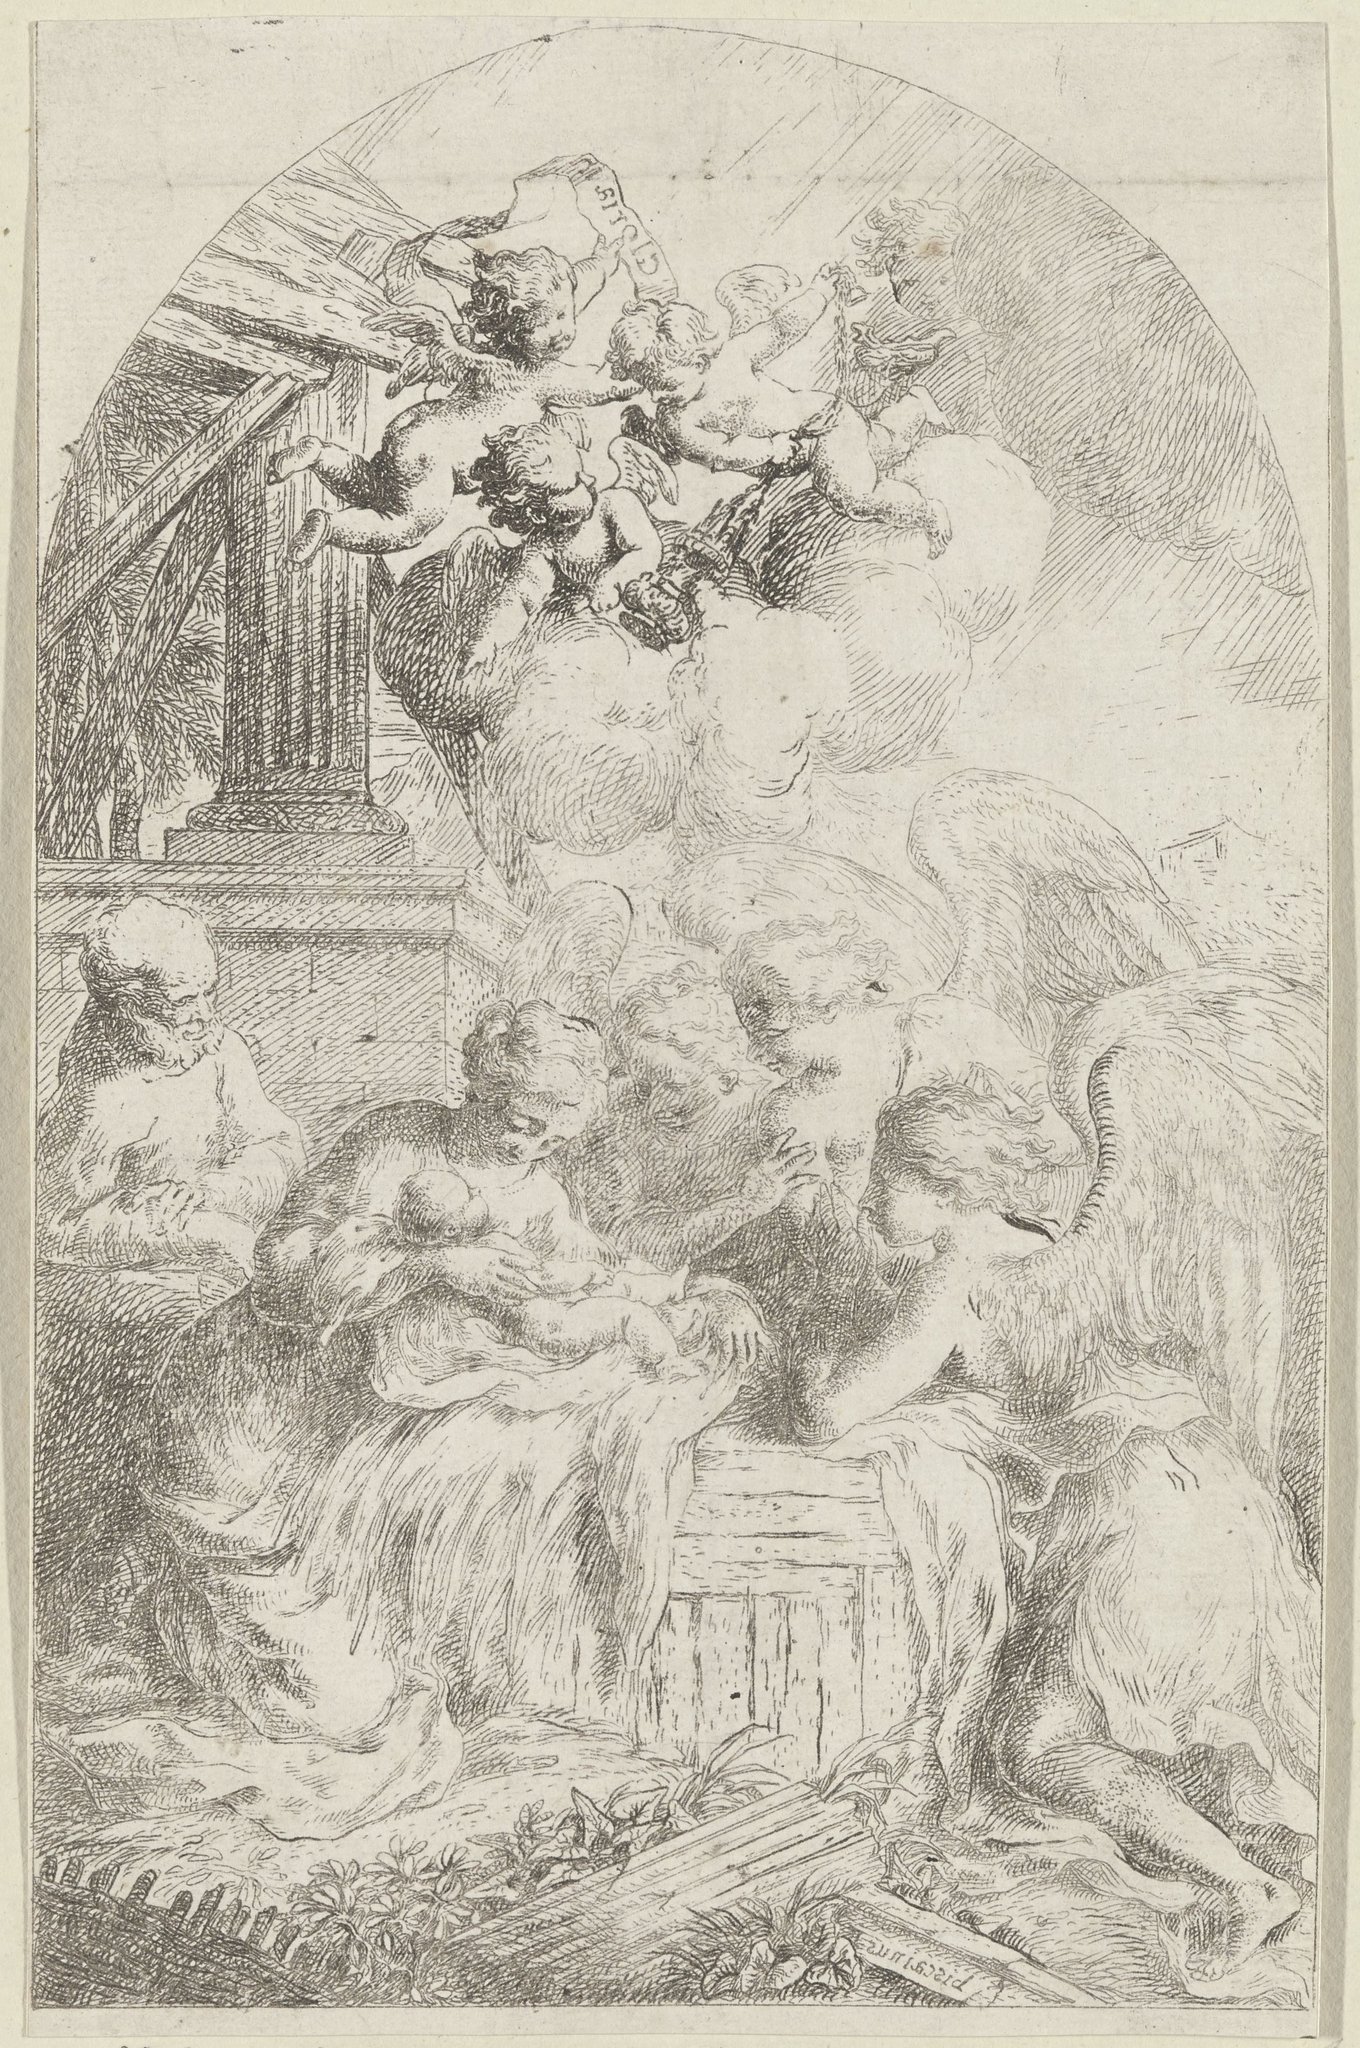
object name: print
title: Christuskind aanbeden door drie engelen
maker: bartolomeo biscaino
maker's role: print maker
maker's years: 1632-1657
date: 1642-1657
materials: paper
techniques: printmaking, etching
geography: italy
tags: holy family, and derived representations (+ angel(s))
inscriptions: collector's mark: Lugt 240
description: Maria toont het Christuskind aan drie engelen. Achter Maria staat Jozef. Boven zweven drie putti.